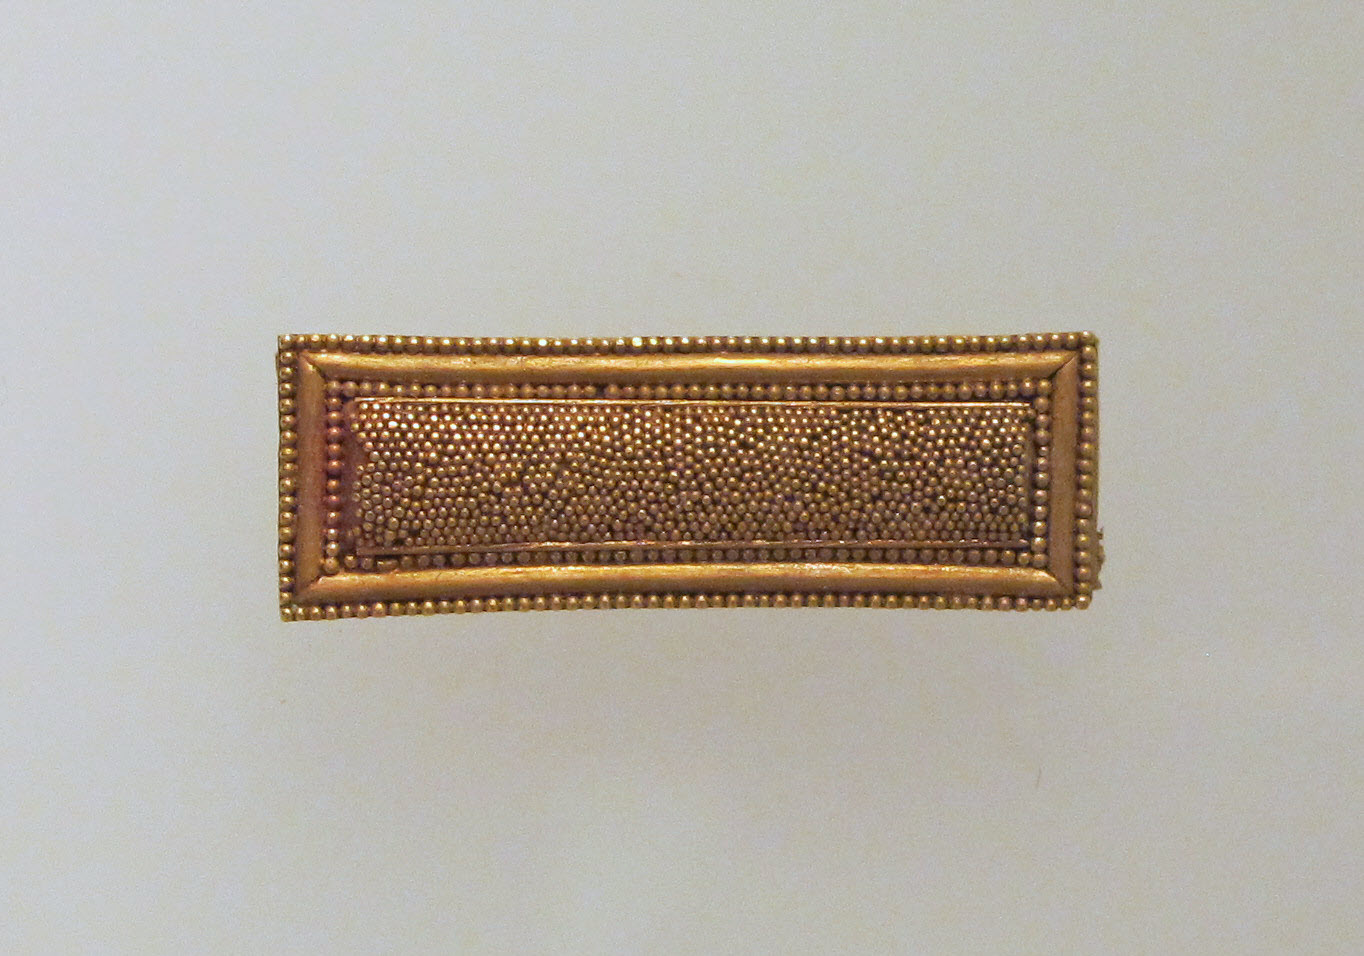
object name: bead, control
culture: cypriot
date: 3900 BCE-100 CE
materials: gold